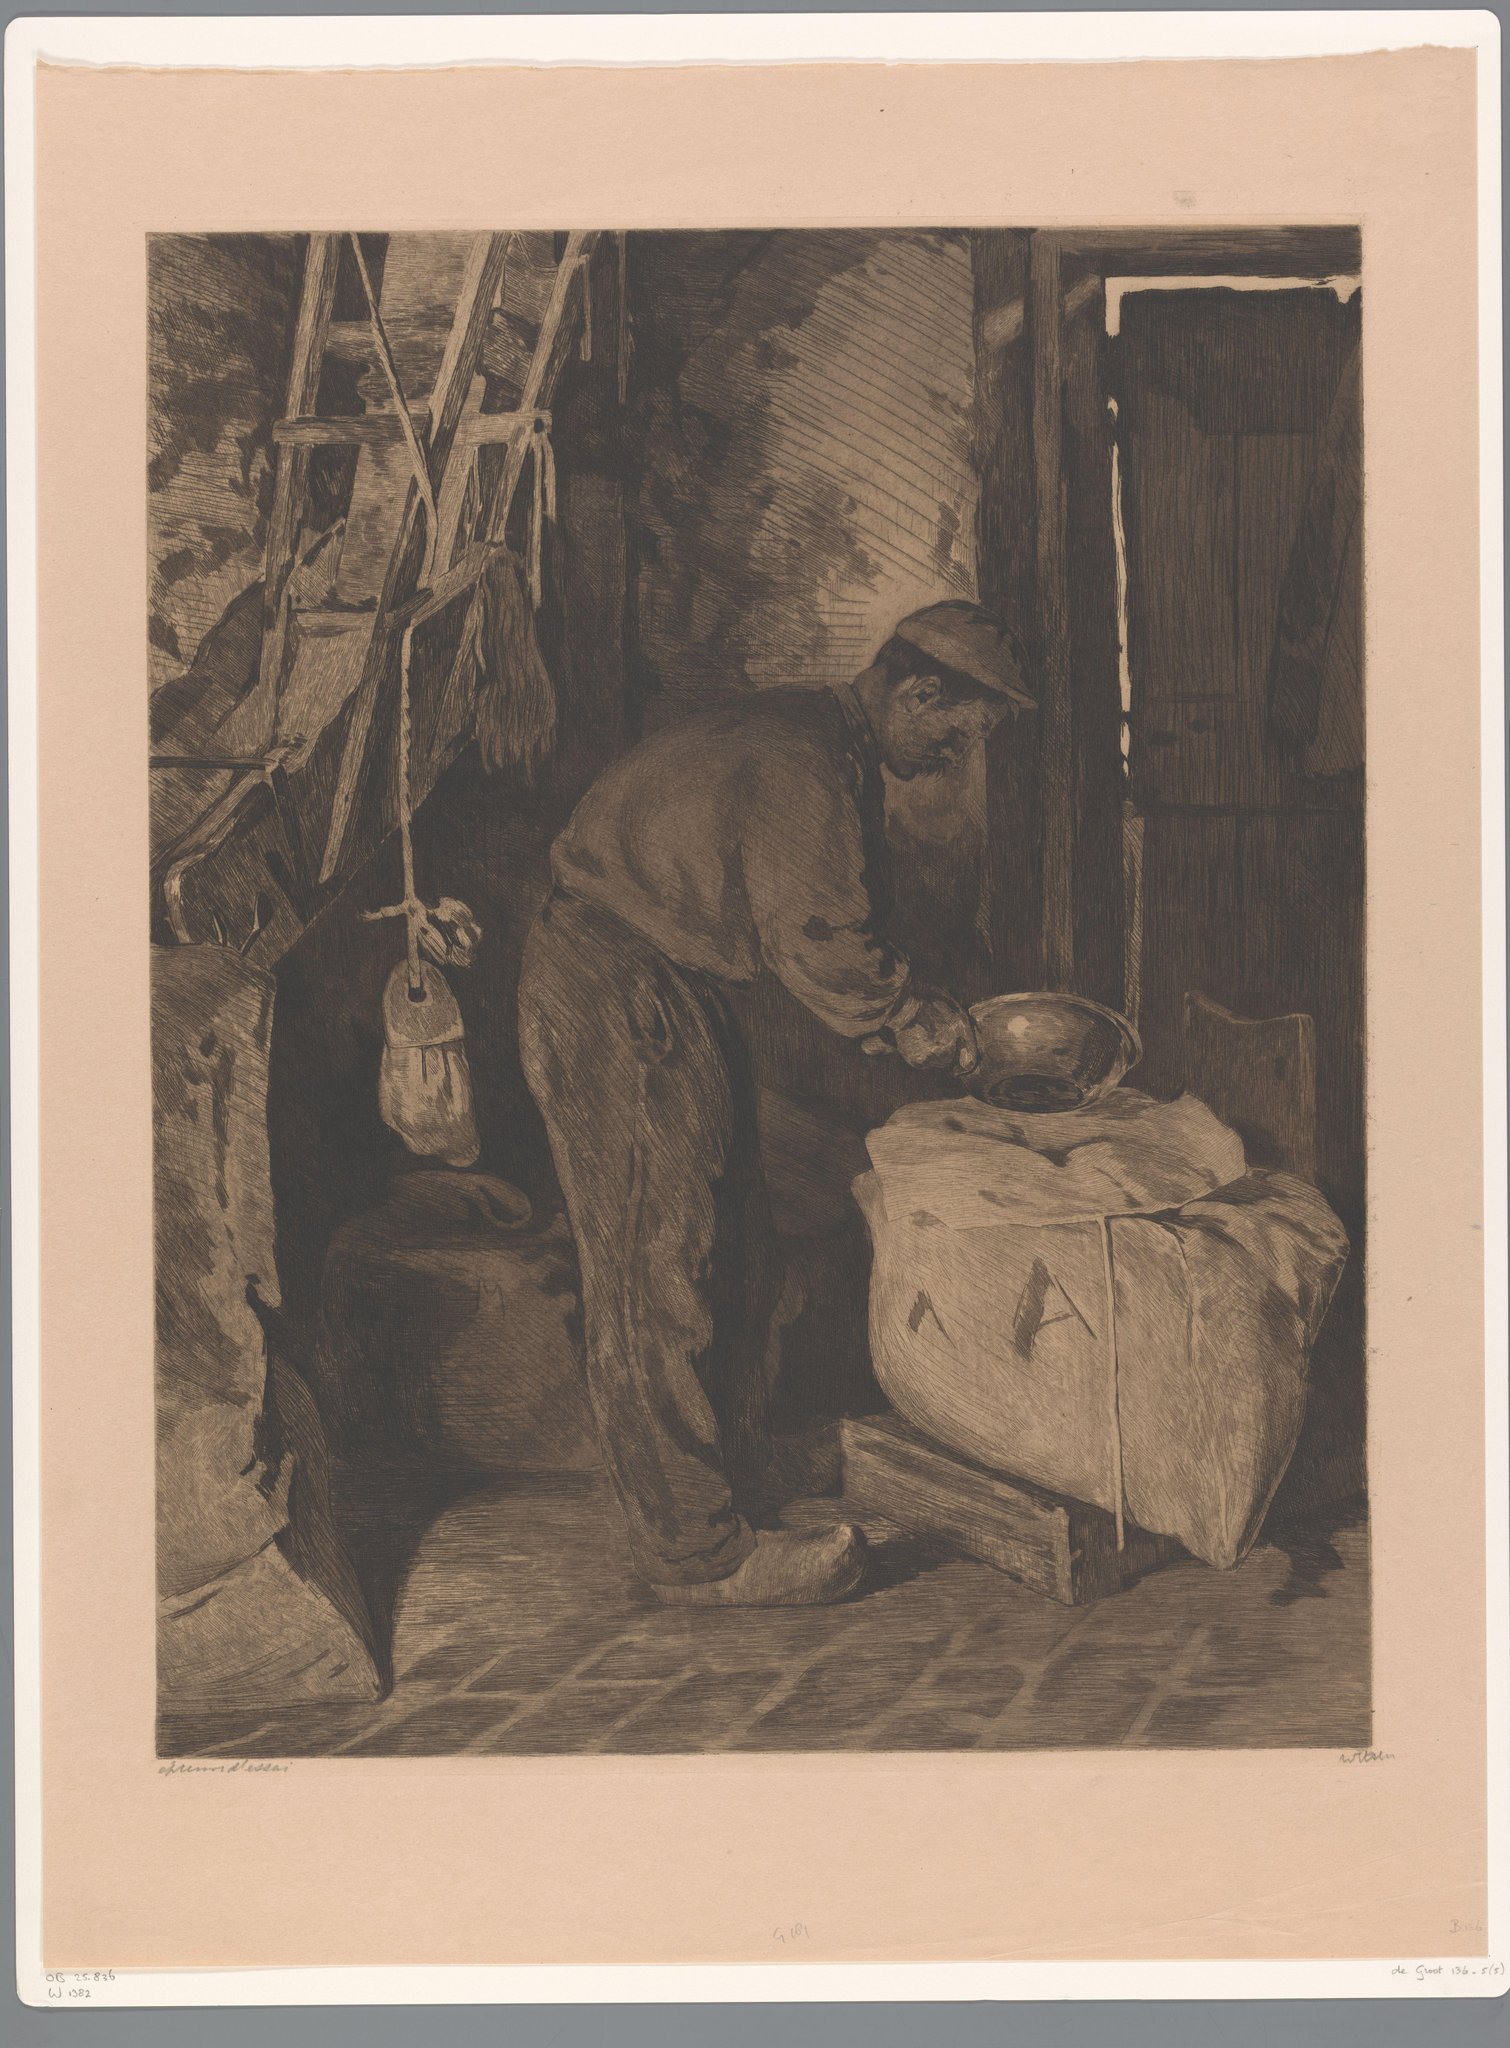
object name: print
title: Molenaar in de korenmolen van Wijk bij Duurstede vult een zak met meel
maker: willem witsen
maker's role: draughtsman, painter, print maker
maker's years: 1860-1923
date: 1908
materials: paper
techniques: aquatint, etching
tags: miller, windmill (+ men (labourers)), wijk bij duurstede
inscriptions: annotation: ‘épreuve d'essai’